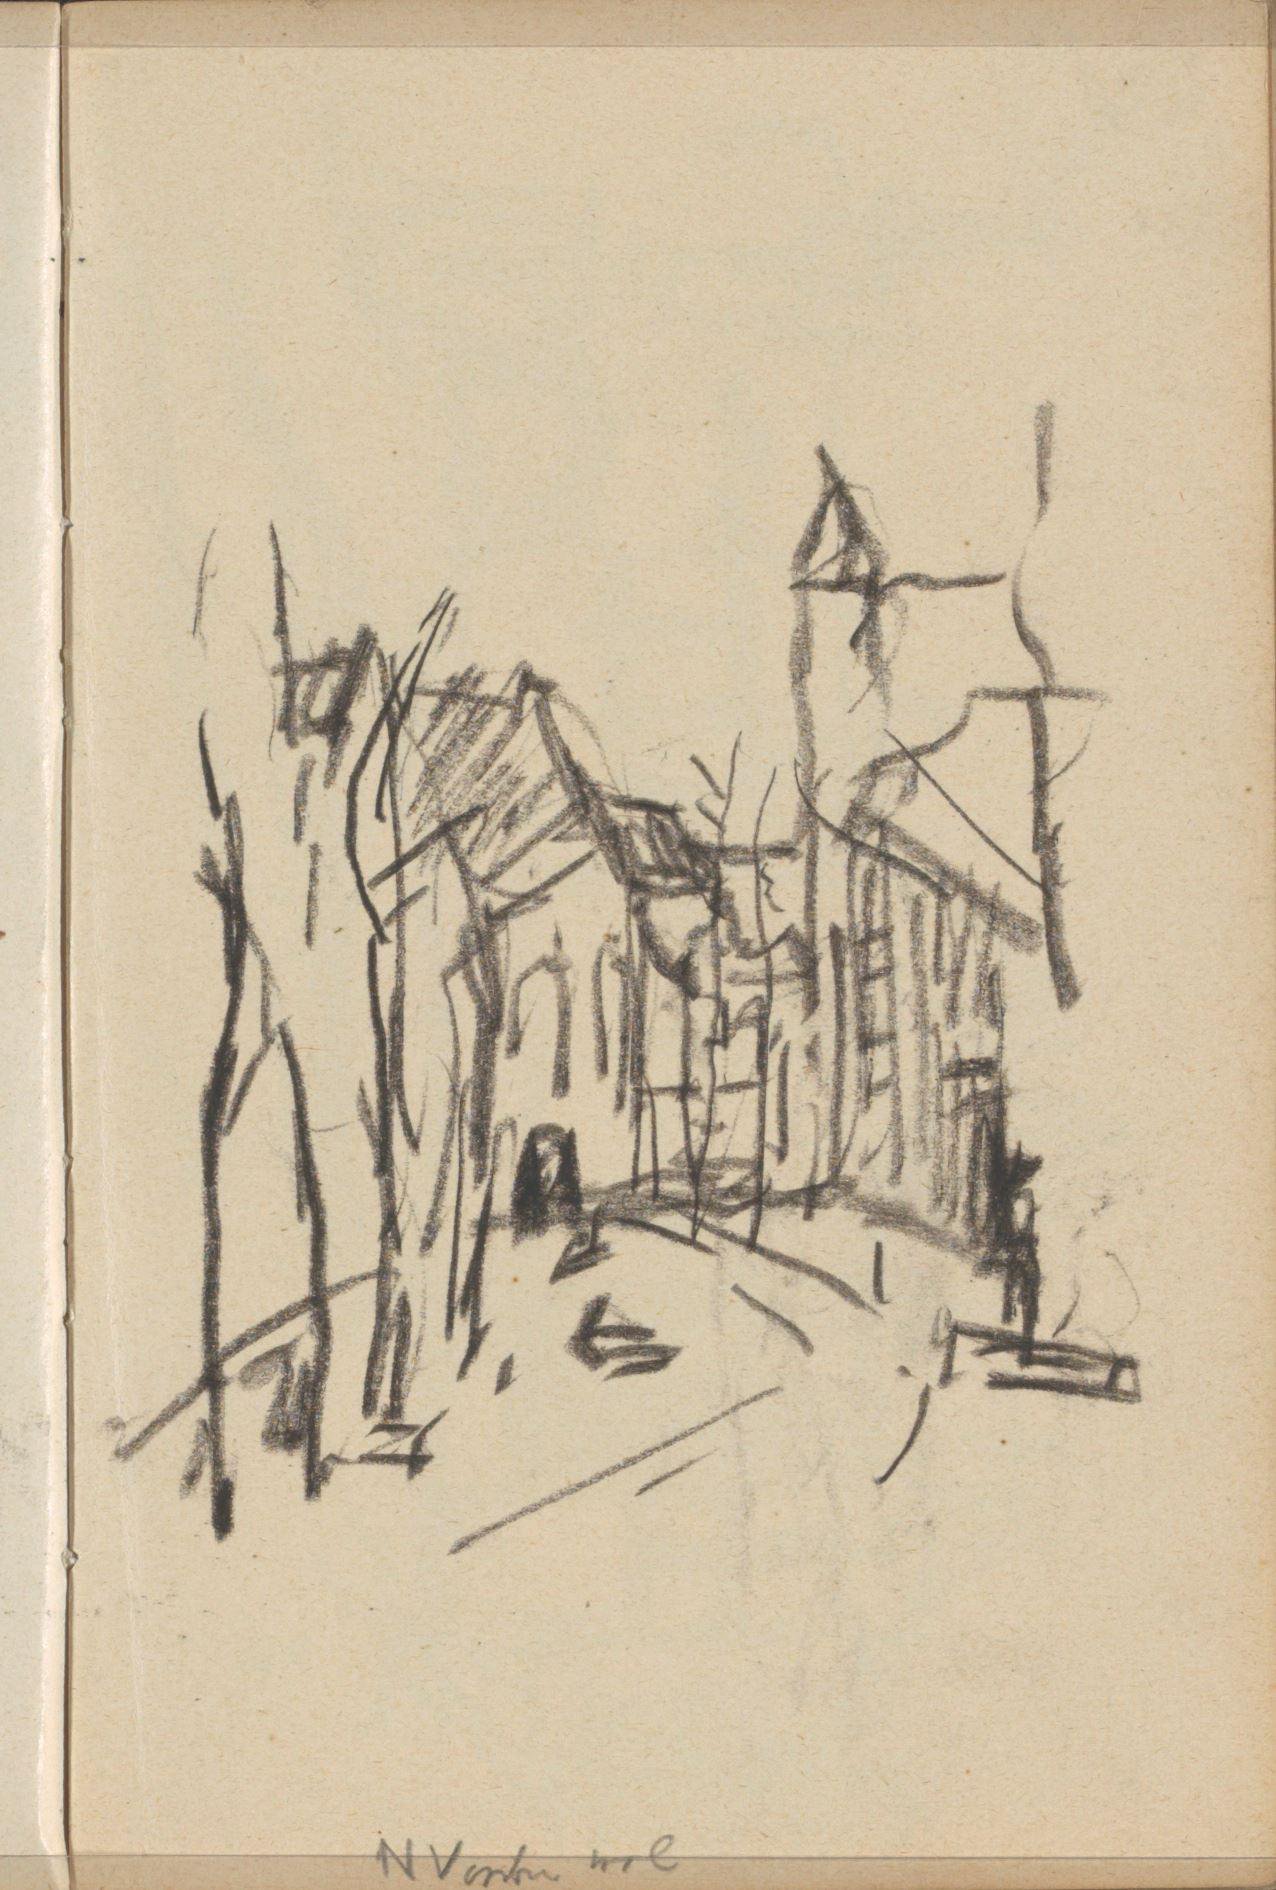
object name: sketchbook leaf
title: Gezicht op de Nieuwezijds Voorburgwal te Amsterdam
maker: george hendrik breitner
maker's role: draughtsman, painter, print maker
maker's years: 1857-1923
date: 1910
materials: chalk, paper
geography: amsterdam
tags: civic architecture; edifices; dwellings, street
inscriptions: annotation: ‘N Voorburg wal’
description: Pagina 32 uit een schetsboek met 45 bladen.